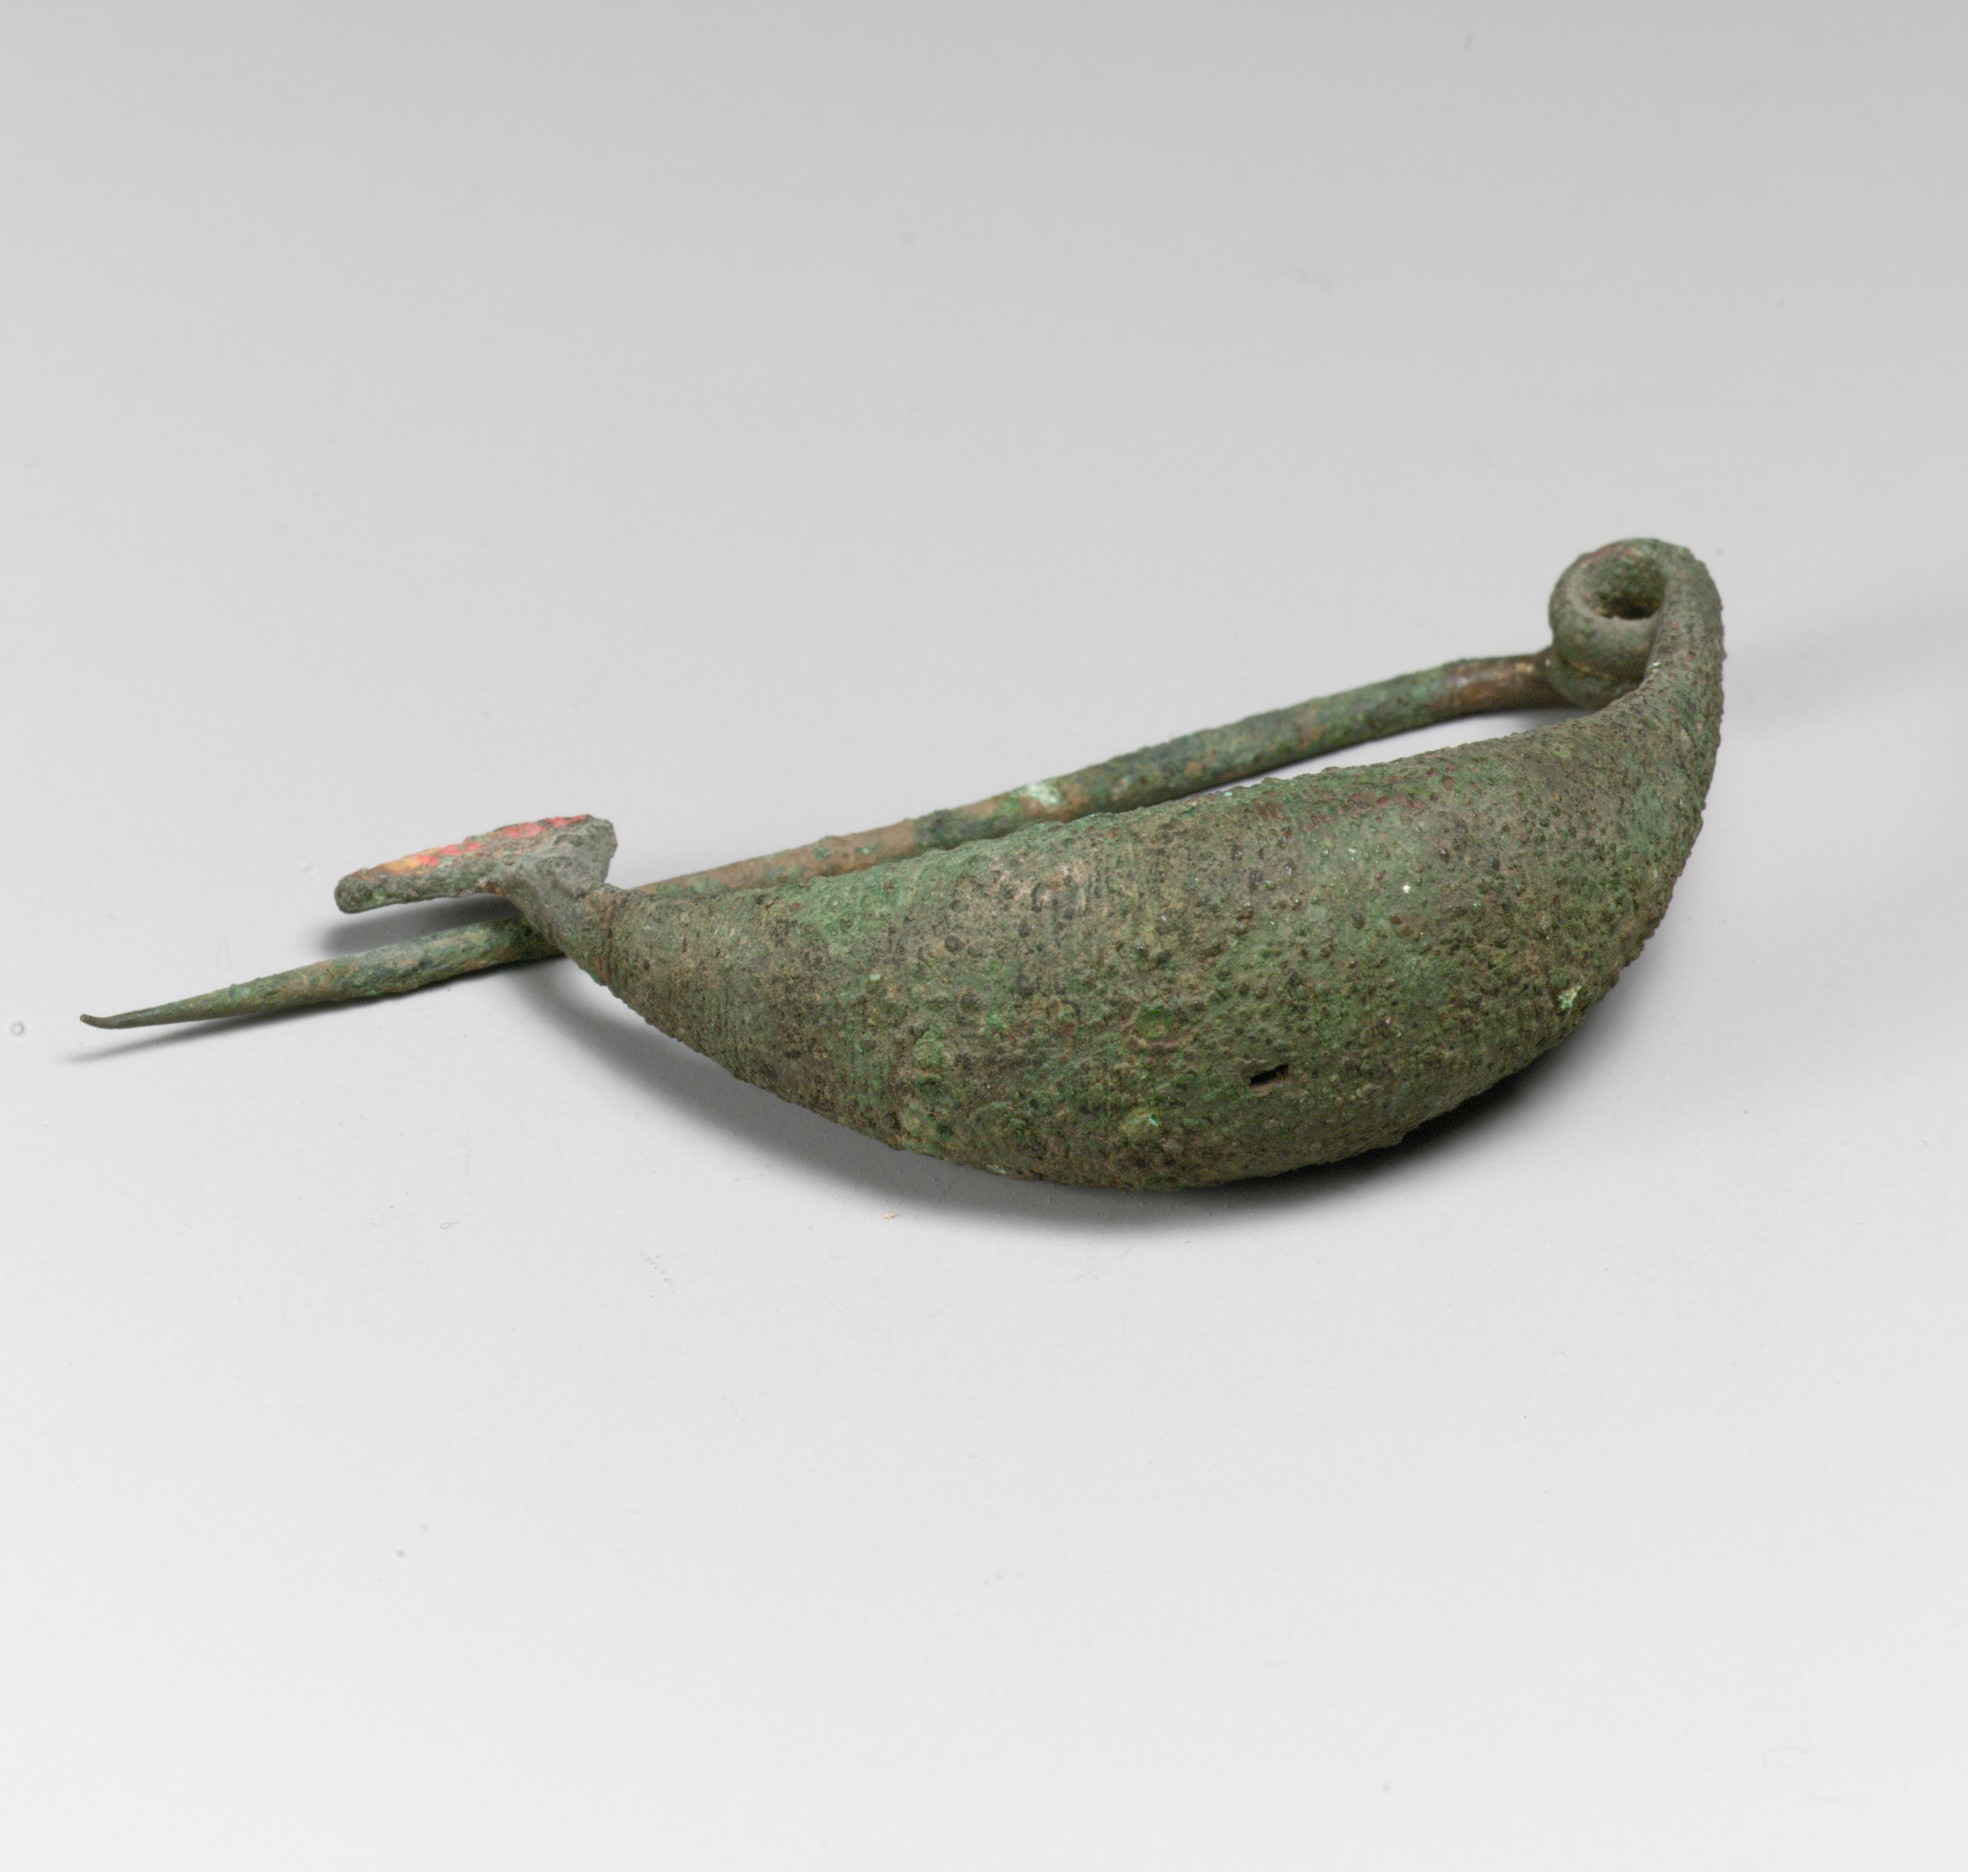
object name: fibula, boat shaped type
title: Fibula, boat-shaped type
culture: italic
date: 800-501 BCE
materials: bronze